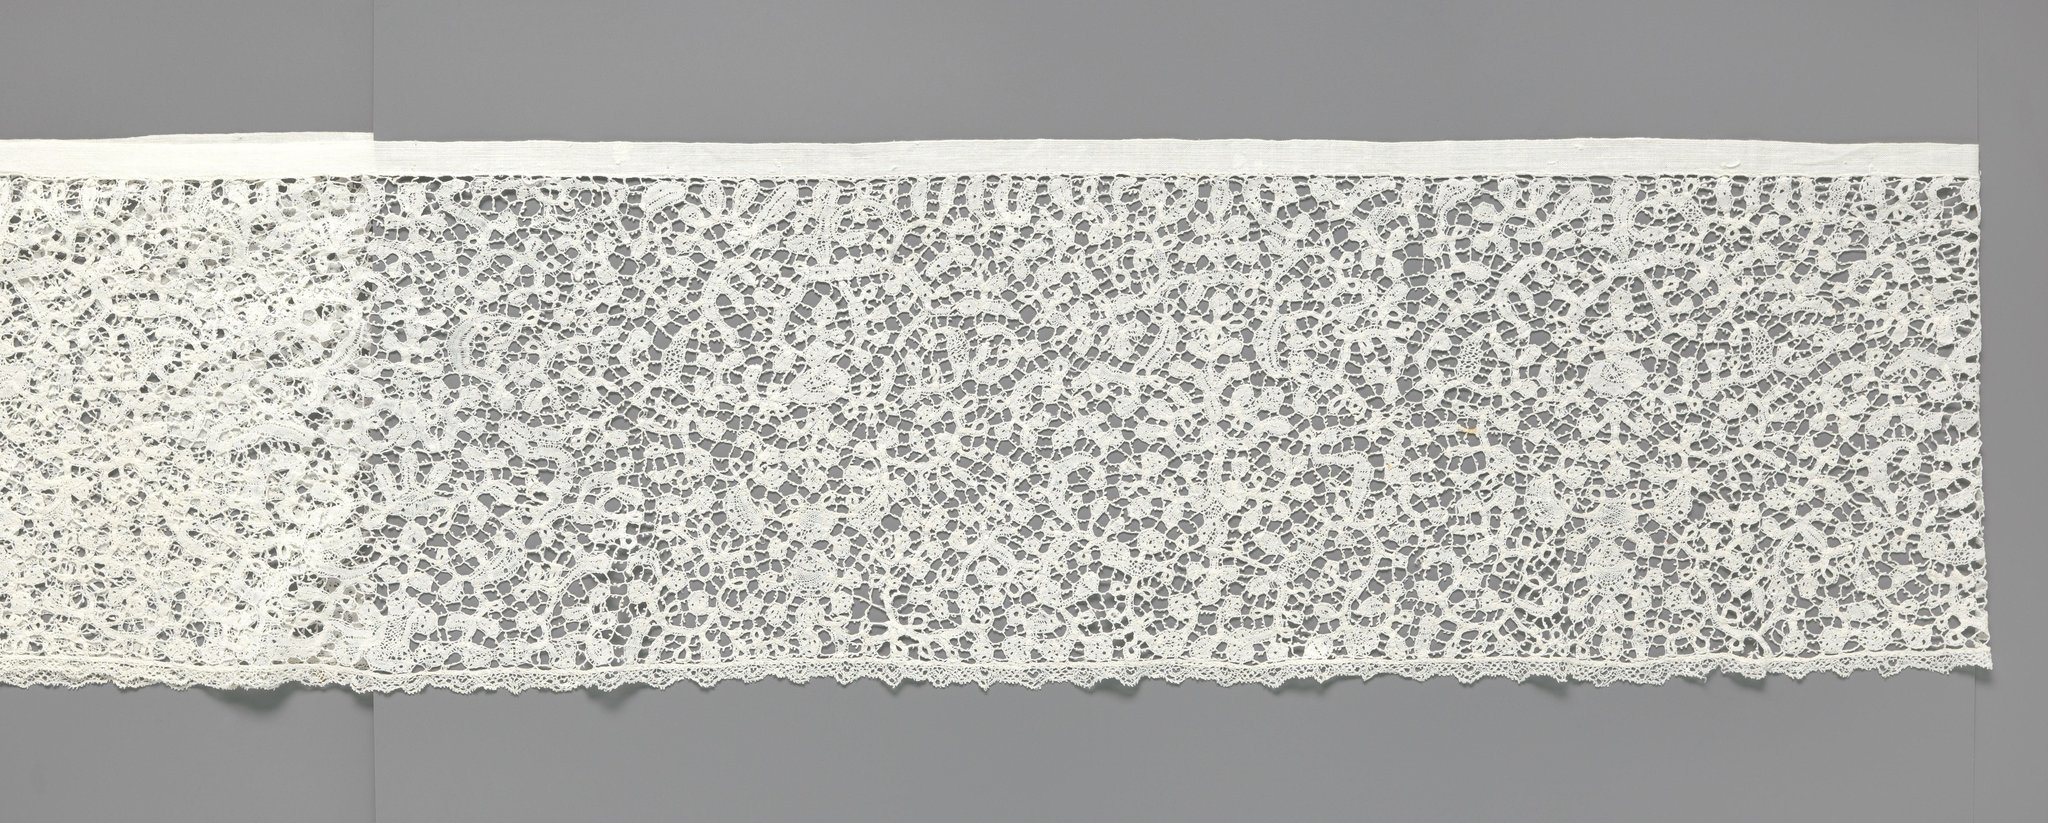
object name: rochet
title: Strook kloskant met kandelabermotieven voor aan een rochet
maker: Anonymous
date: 1685-1799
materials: linen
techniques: lace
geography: southern netherlands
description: Strook naturelkleurige kloskant: Vlaamse guipurekant. De strook is gebruikt of bedoeld voor aan een rochet. Het zich herhalende patroon wordt gevormd door linten gemaakt in linnenslag en bestaat uit twee afwisselende symmetrische kandelabermotieven, die de gehele breedte vullen. De linten zijn met elkaar verbonden door een onregelmatige vlechtengrond. Er zijn enkele siersteken toegepast. Het schulpenrandje is aangezet.